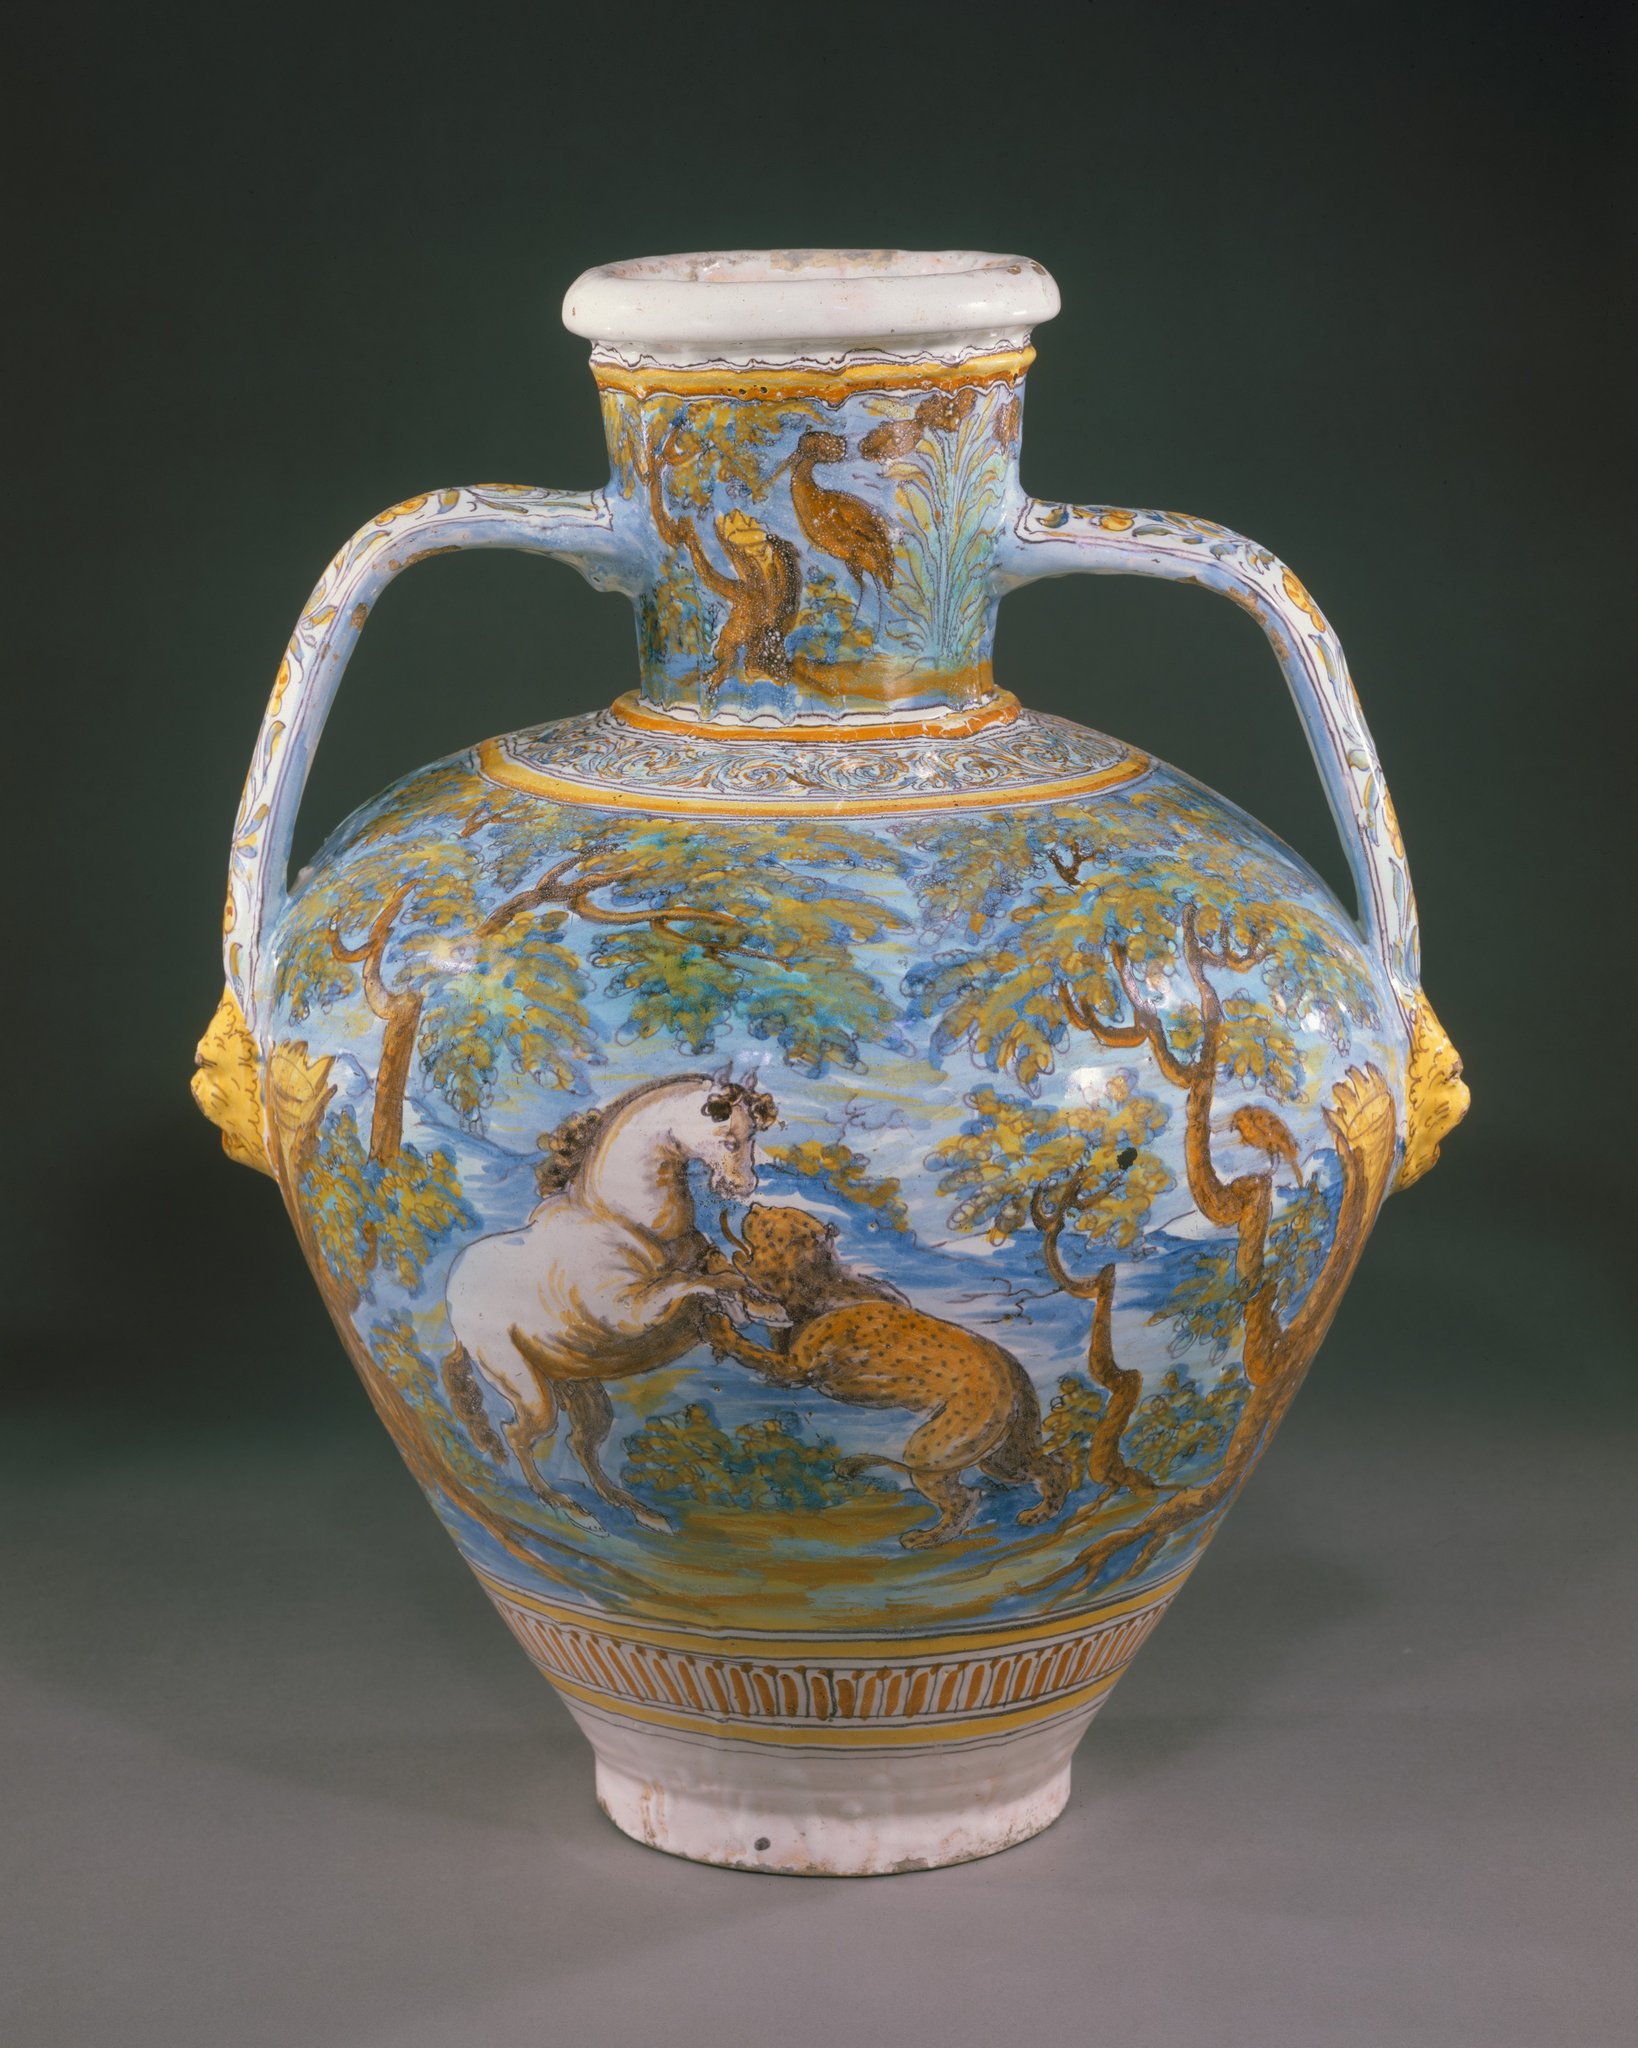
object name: jar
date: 1625-1650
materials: earthenware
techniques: glazing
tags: animals,birds,horses,trees